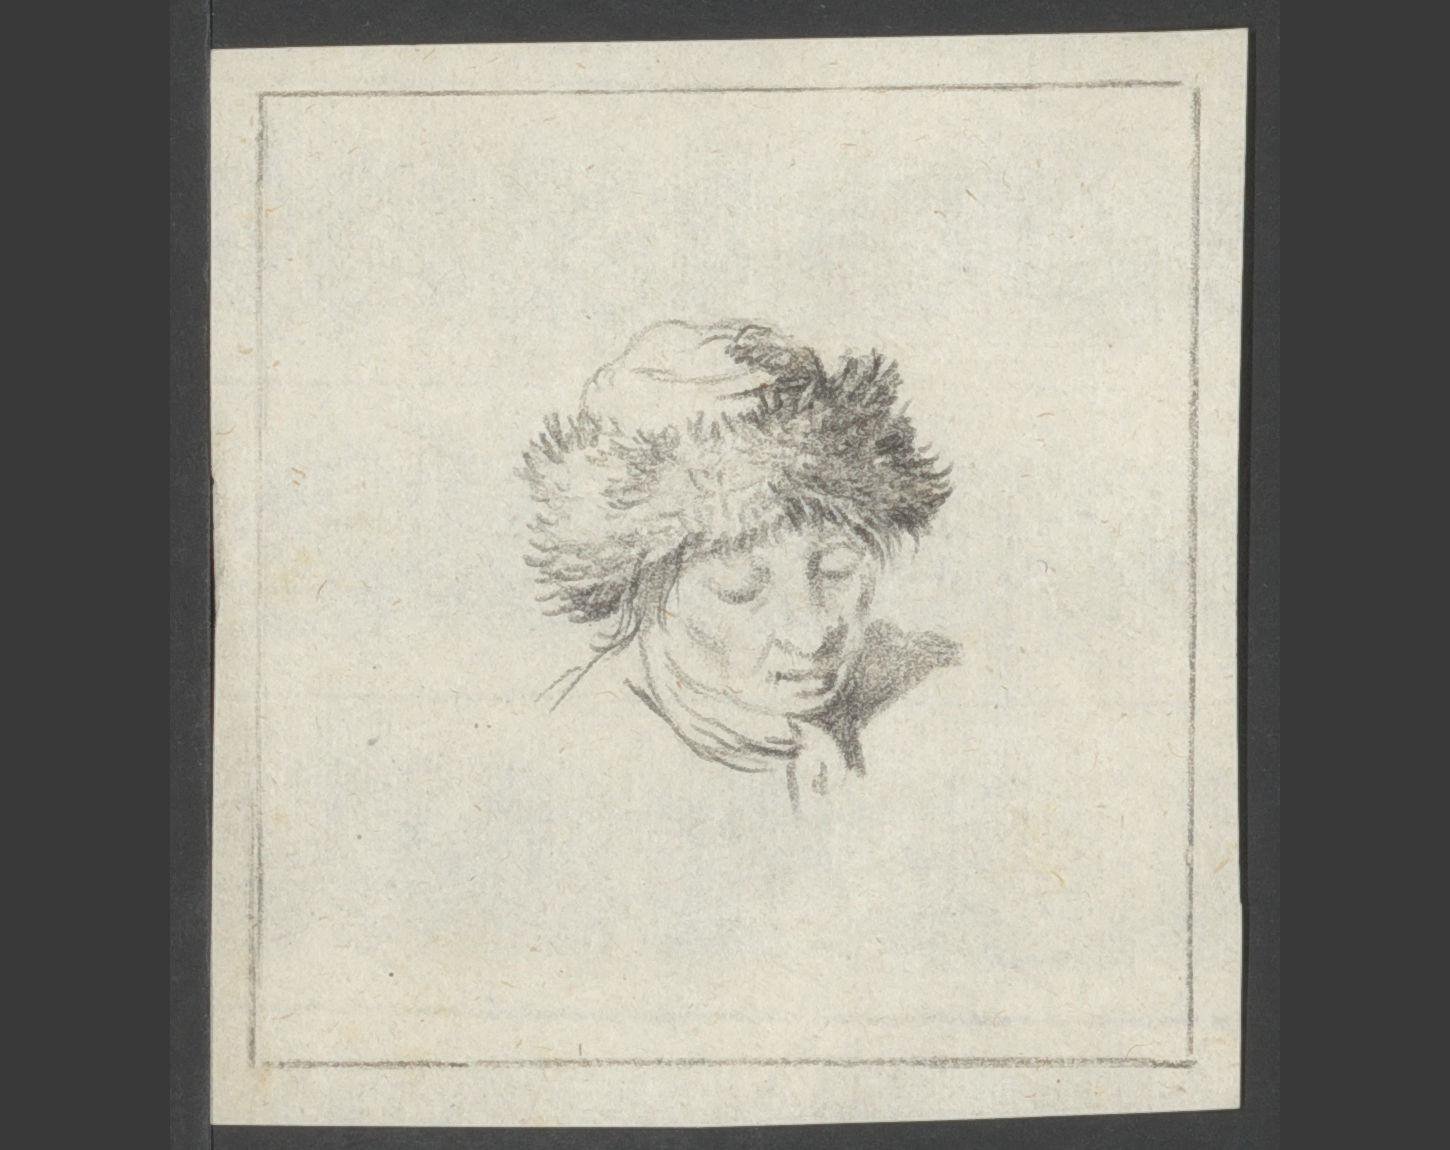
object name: drawing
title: Oude man met bontmuts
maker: Anonymous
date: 1800-1899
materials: chalk, paper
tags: old man, head-gear: cap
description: Onderwerpsrubrieken binnen de Atlas Zeden en Gewoonten: Schoone kunsten, Schilderkunst, Tekeningen.